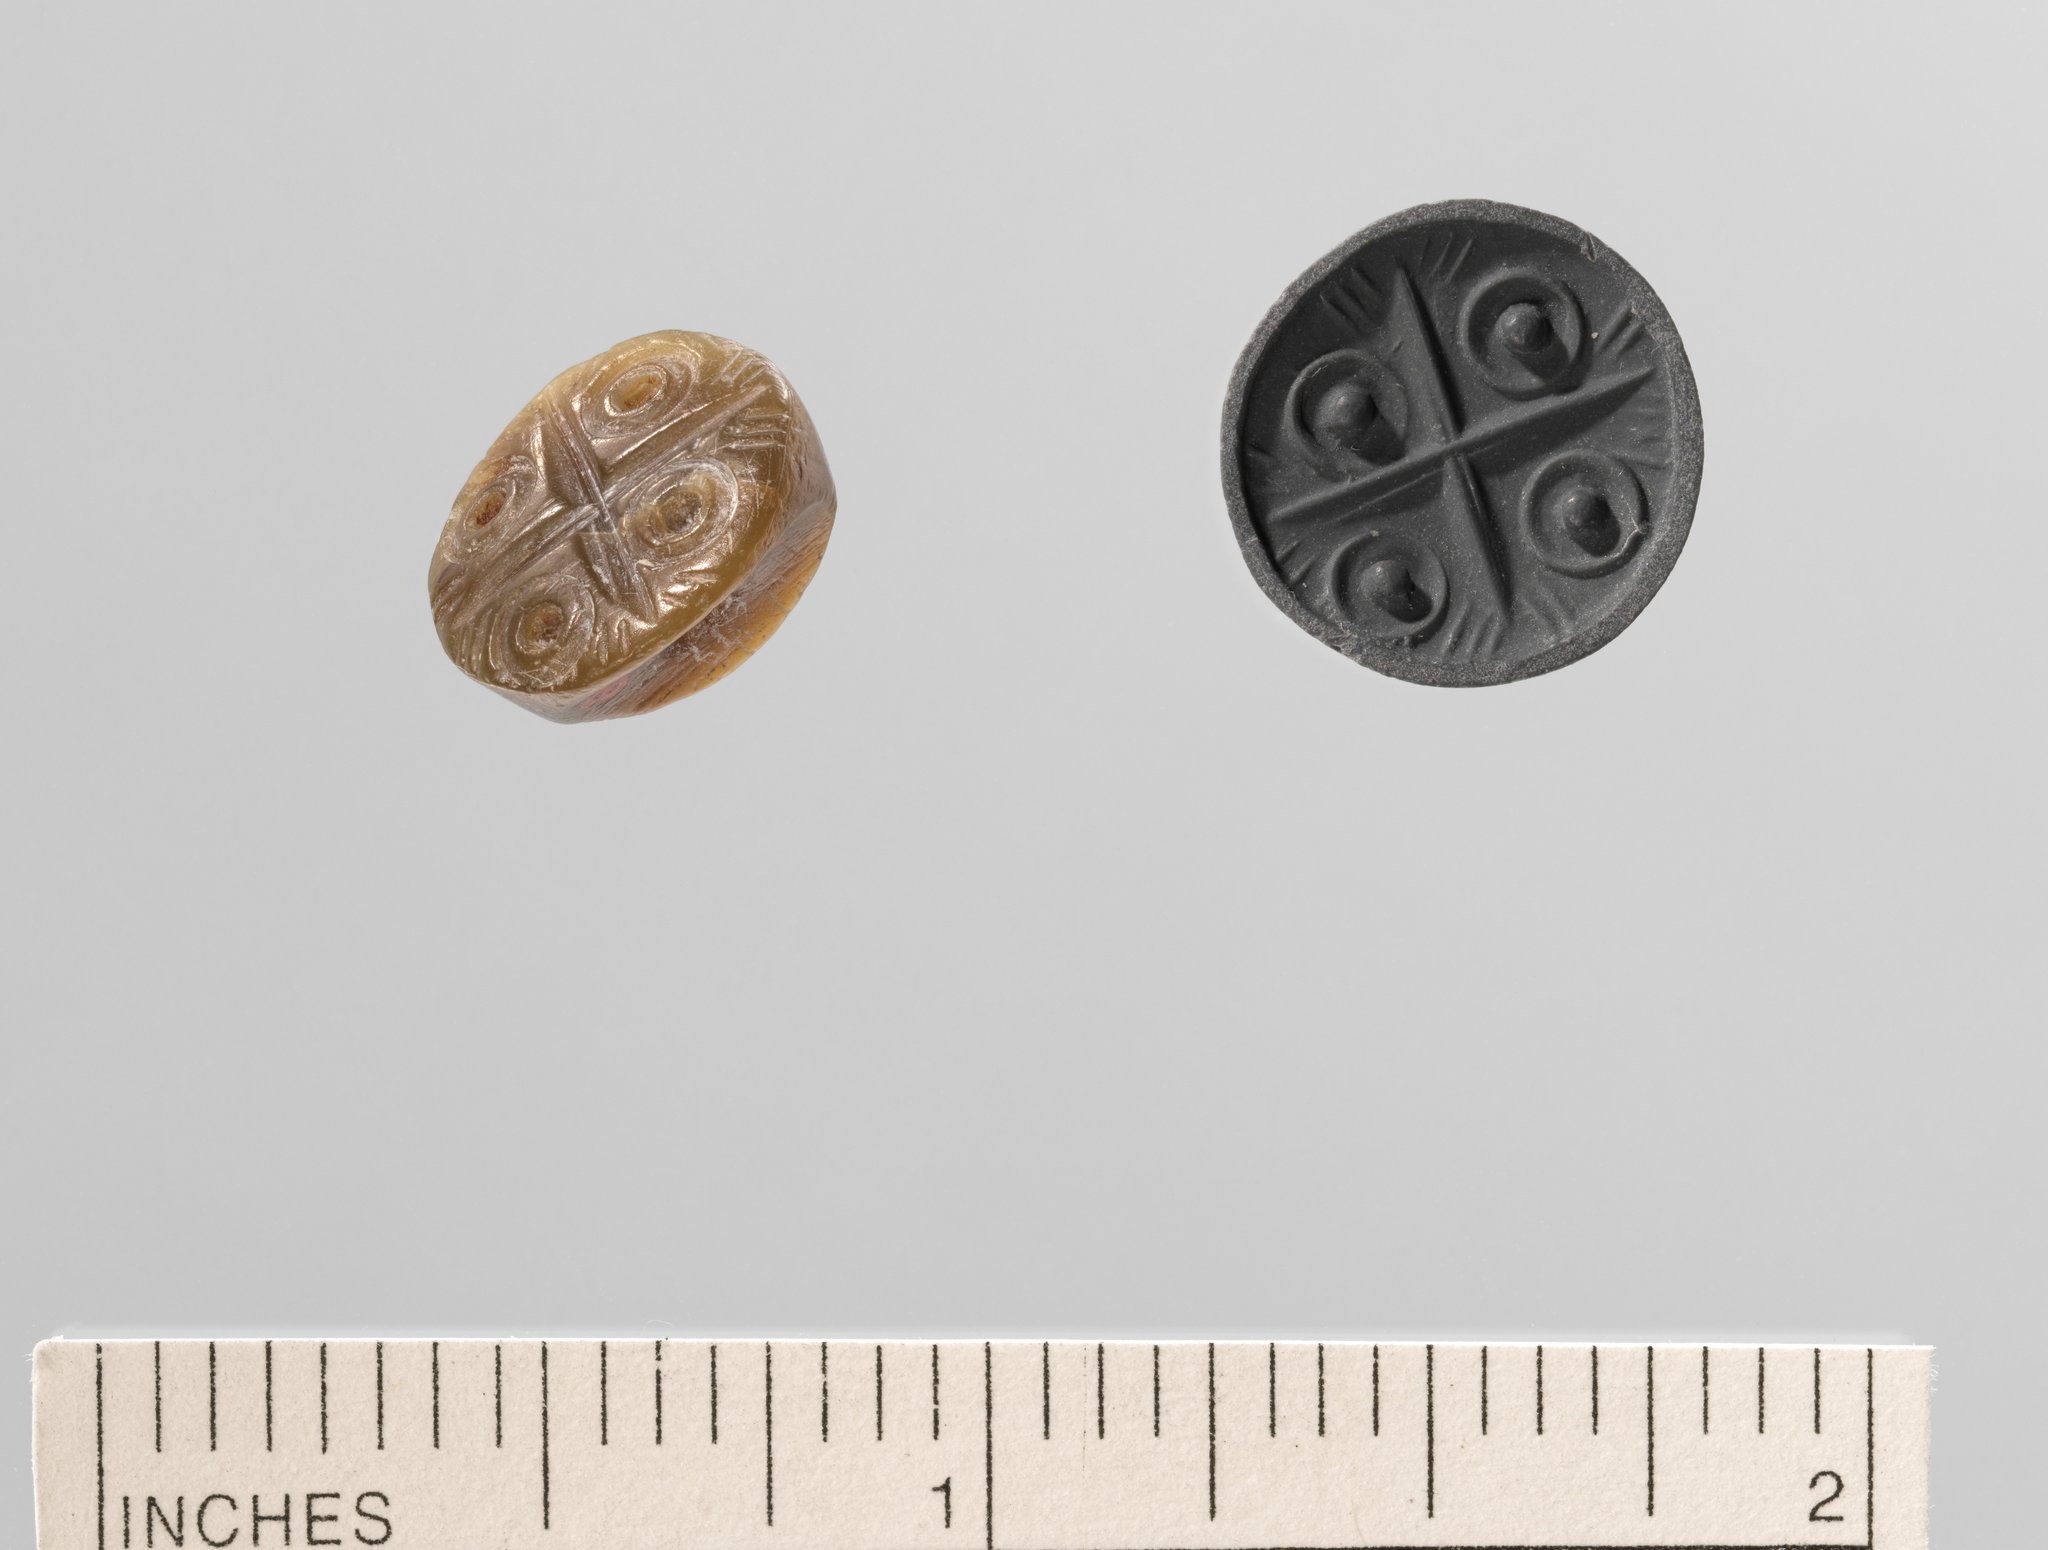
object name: stamp seal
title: Steatite Stamp Seal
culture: minoan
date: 1800-1700 BCE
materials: stone